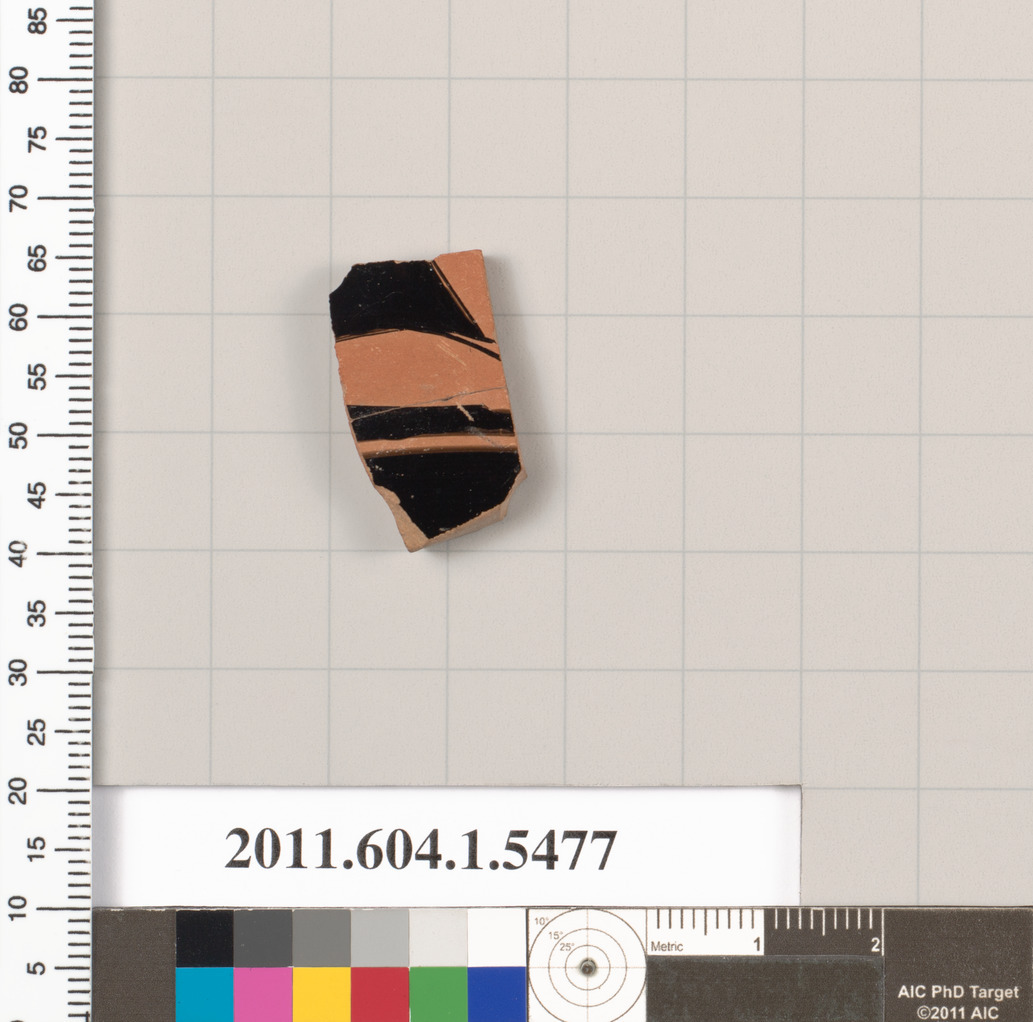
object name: kylix fragment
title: Terracotta fragment of a kylix (drinking cup)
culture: greek, attic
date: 500-490 BCE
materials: terracotta